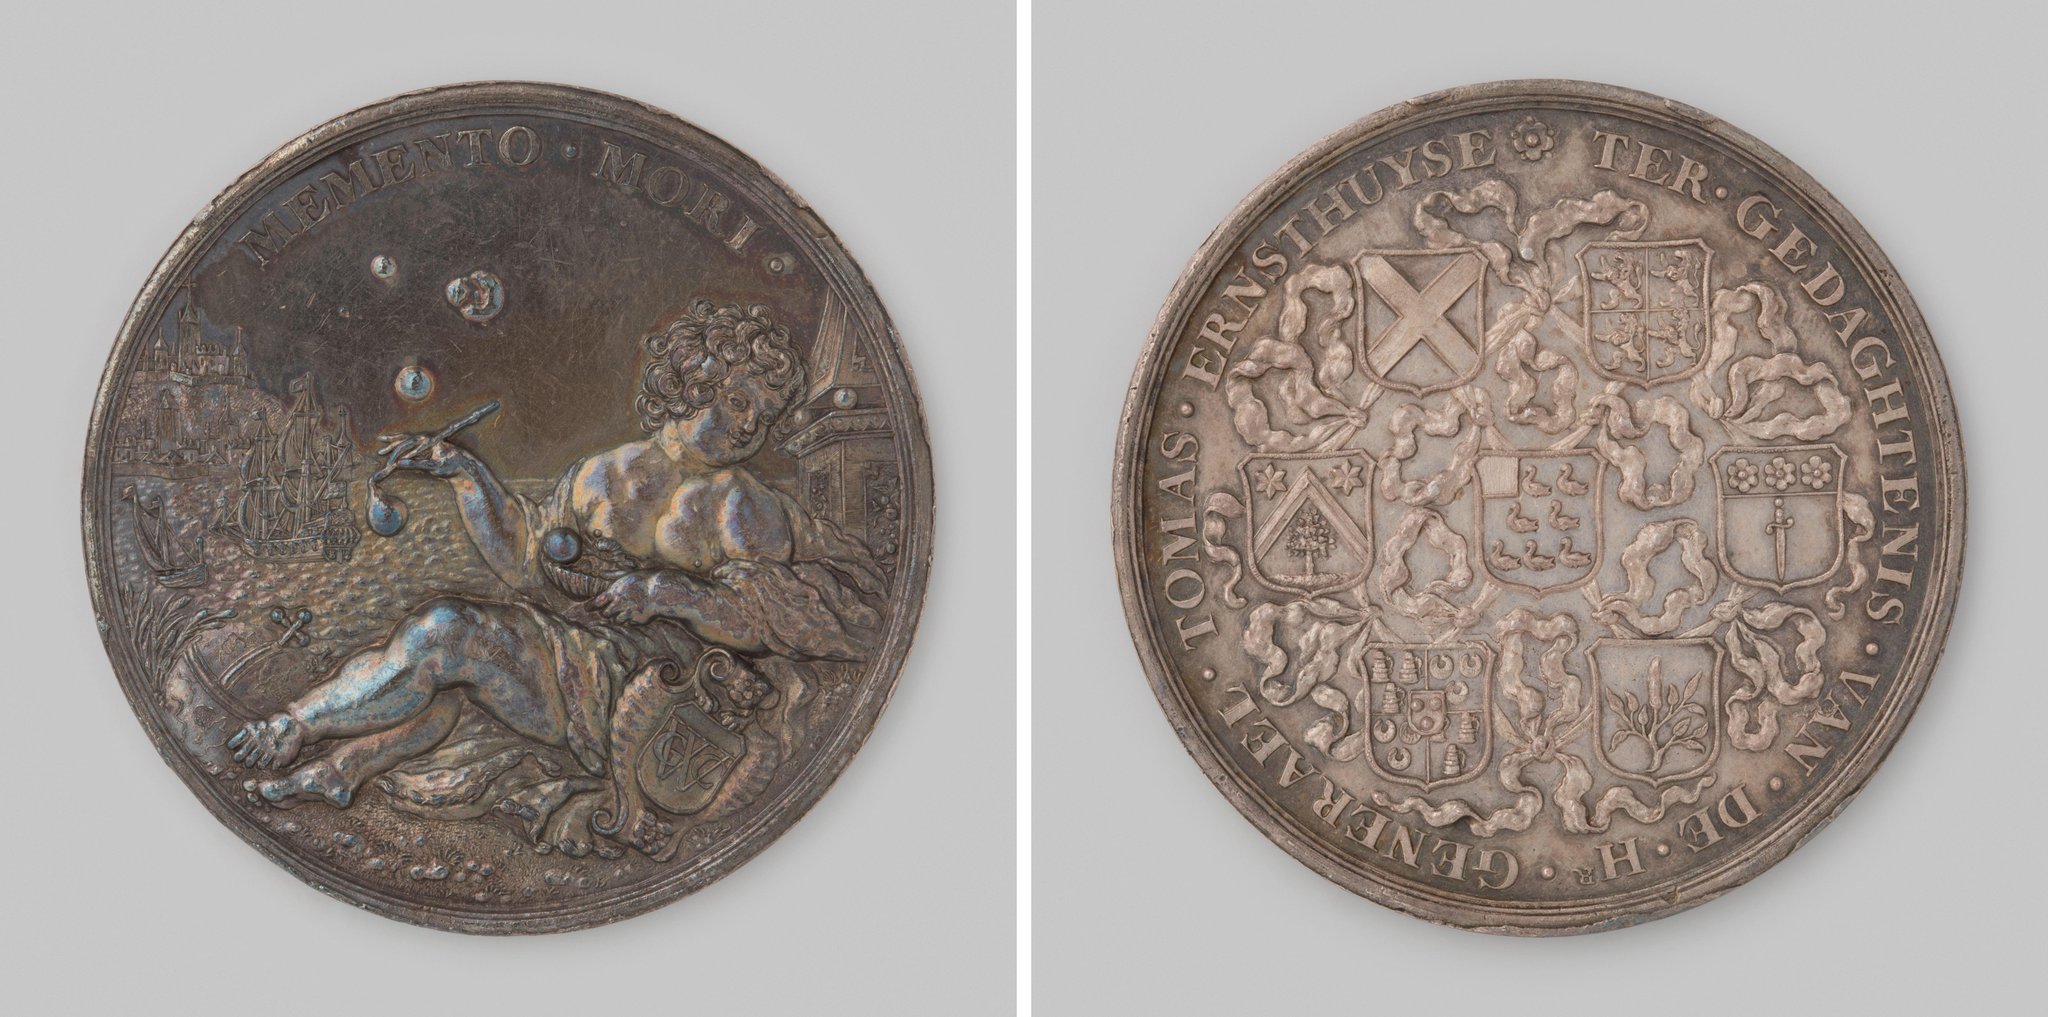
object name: history medal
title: Overlijden van Thomas Ernsthuyse, generaal ter Kuste van Guinea 1683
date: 1683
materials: silver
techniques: striking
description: Zilveren penning, op de voorzijde een bellenblazende knaap tegen een grafmonument, onder zijn arm het wapen der GWC, aan zijn voeten een aardbol, op de achtergrond Elmina, met omschrift, op de keerzijde zeven met lint samengebonden wapenschilden met omschrift.